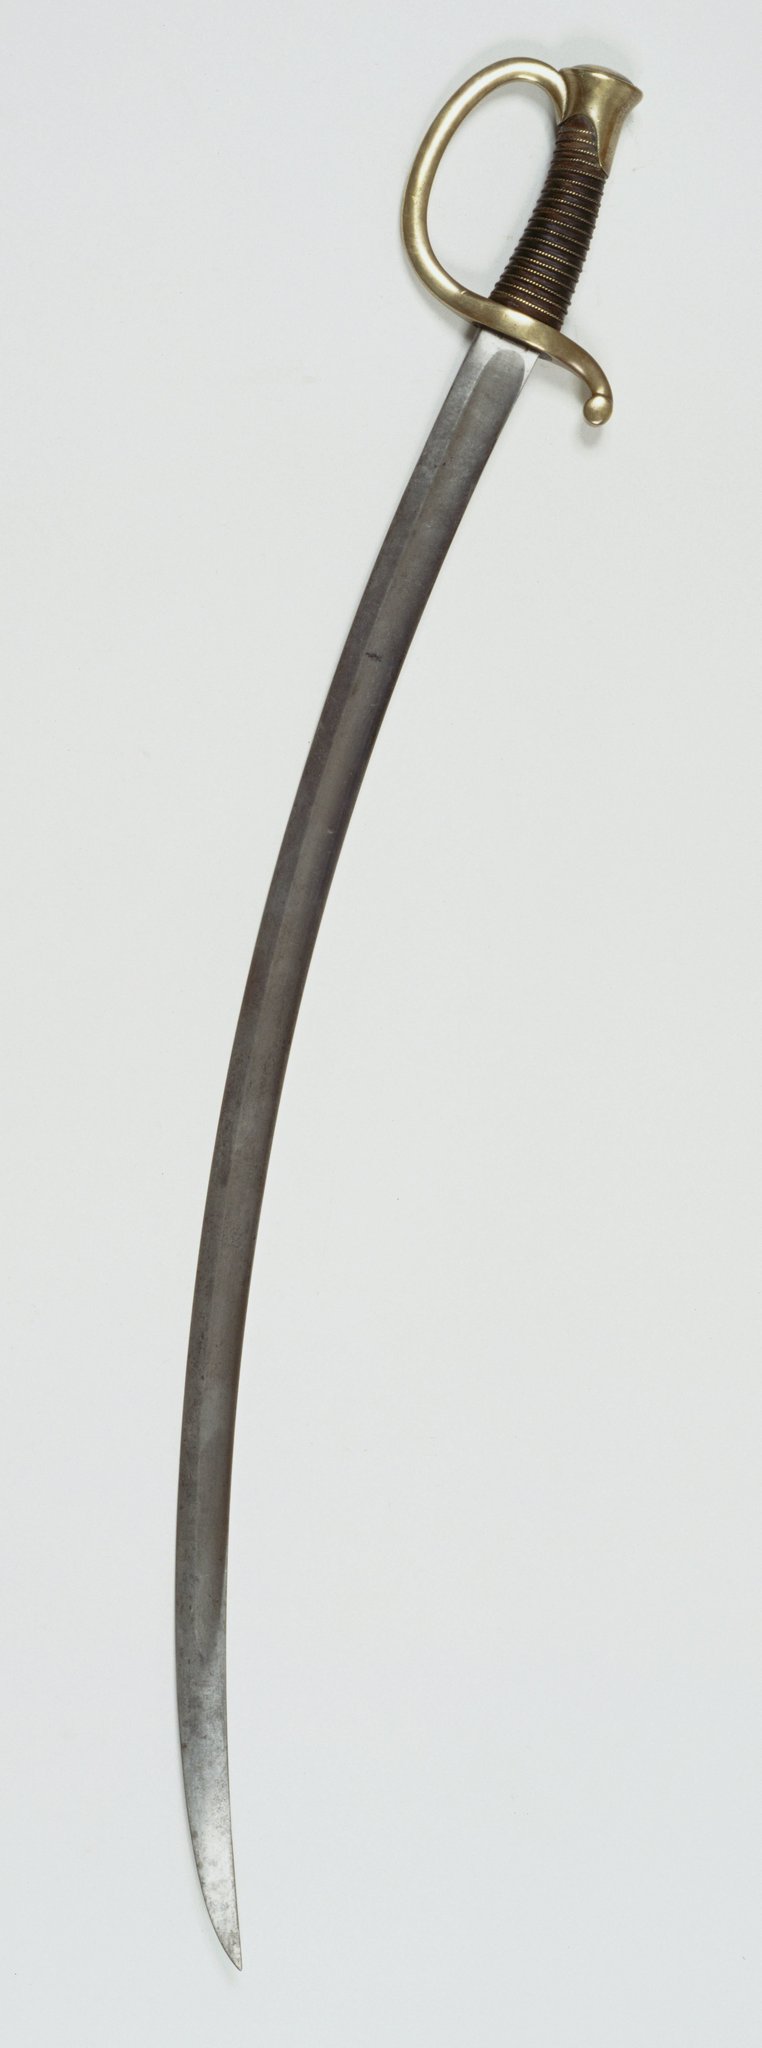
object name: sabre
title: Sabel der Franse artillerie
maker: Anonymous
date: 1854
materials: brass, iron, leather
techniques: braiding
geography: france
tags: france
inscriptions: : ‘Manufacture Impériale Chattelbert. Febr. 1854’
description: Sabel Franse artillerie zonder schede. Zwaar messing gevest met één beugel. Pareerstang met naar beneden gebogen krul. Messing kop. Greep met leer en gevlochten messing draad. Op het gevest 'no 2983' en twee doorgeslagen nummers. Drie keuringsmerken. Op de rug van de kling staat 'Manufacture Impériale Chattelbert. Febr. 1854'. Uitholling tot 15 cm.